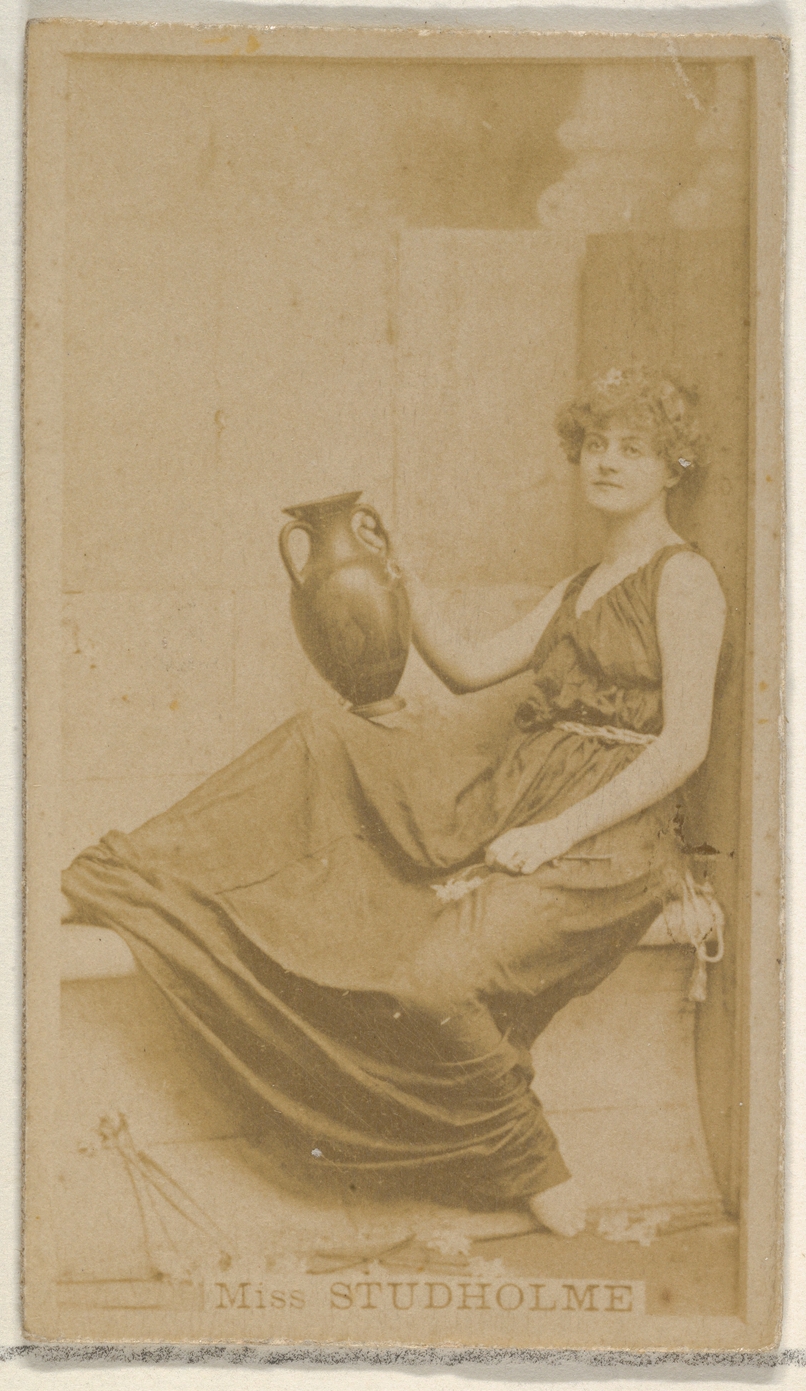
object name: photograph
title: Miss Marie Studholme, from the Actors and Actresses series (N45, Type 8) for Virginia Brights Cigarettes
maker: allen & ginter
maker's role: publisher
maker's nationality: american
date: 1888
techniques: albumen silver print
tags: portraits,women,actresses